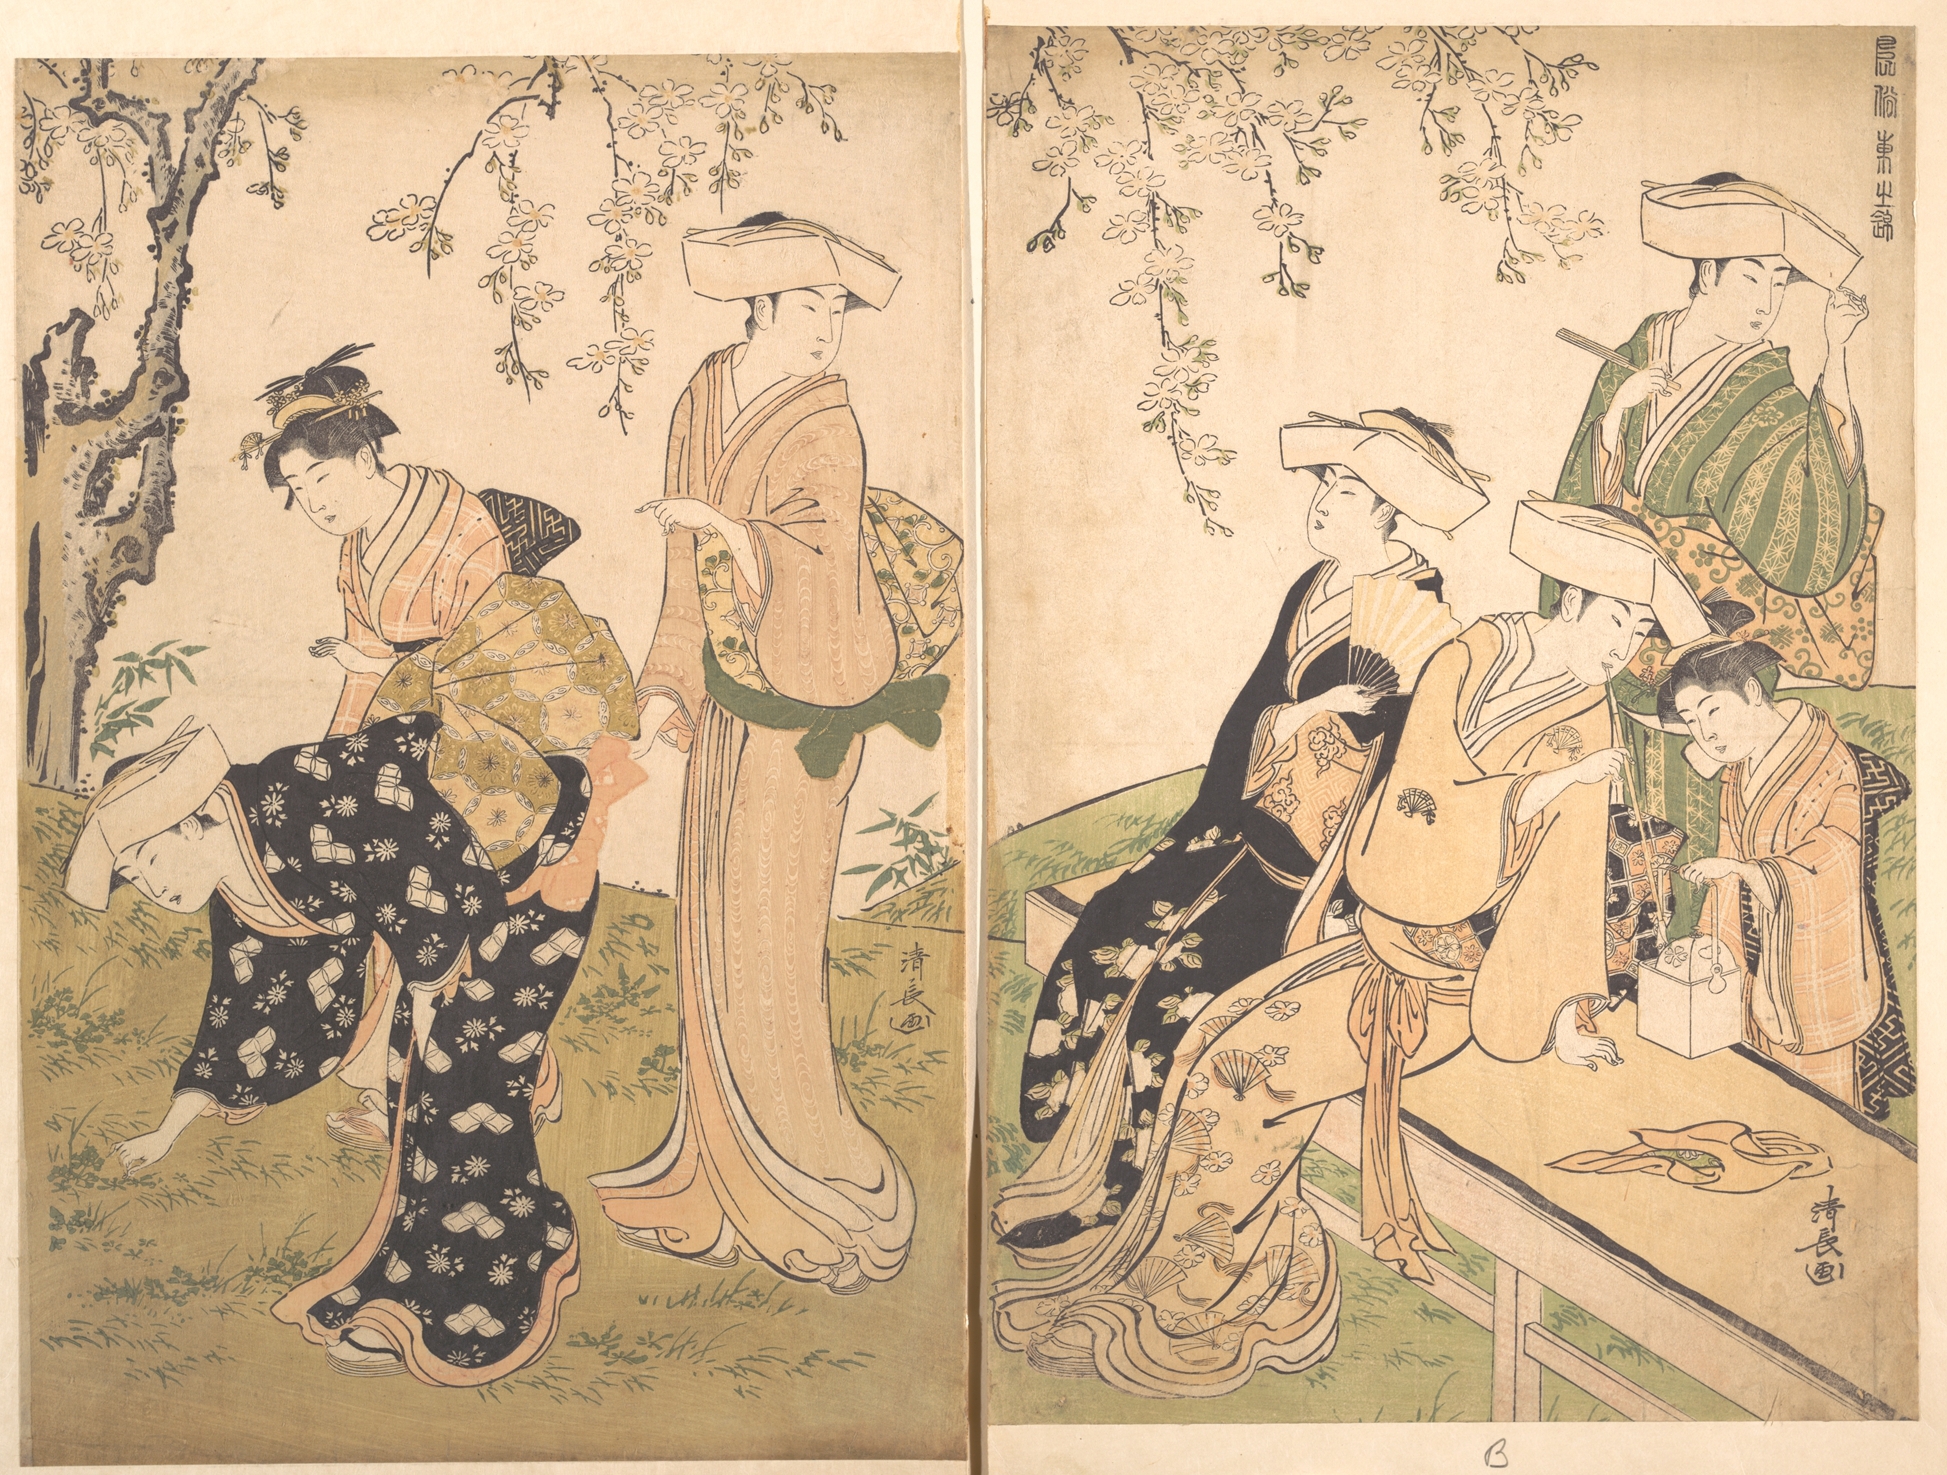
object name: woodblock print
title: Group of Women Under a Blossoming Cherry Tree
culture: japanese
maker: torii kiyonaga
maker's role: artist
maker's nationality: japanese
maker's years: 1752-1815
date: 1784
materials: ink, paper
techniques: woodblock print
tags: women,flowers,trees,working